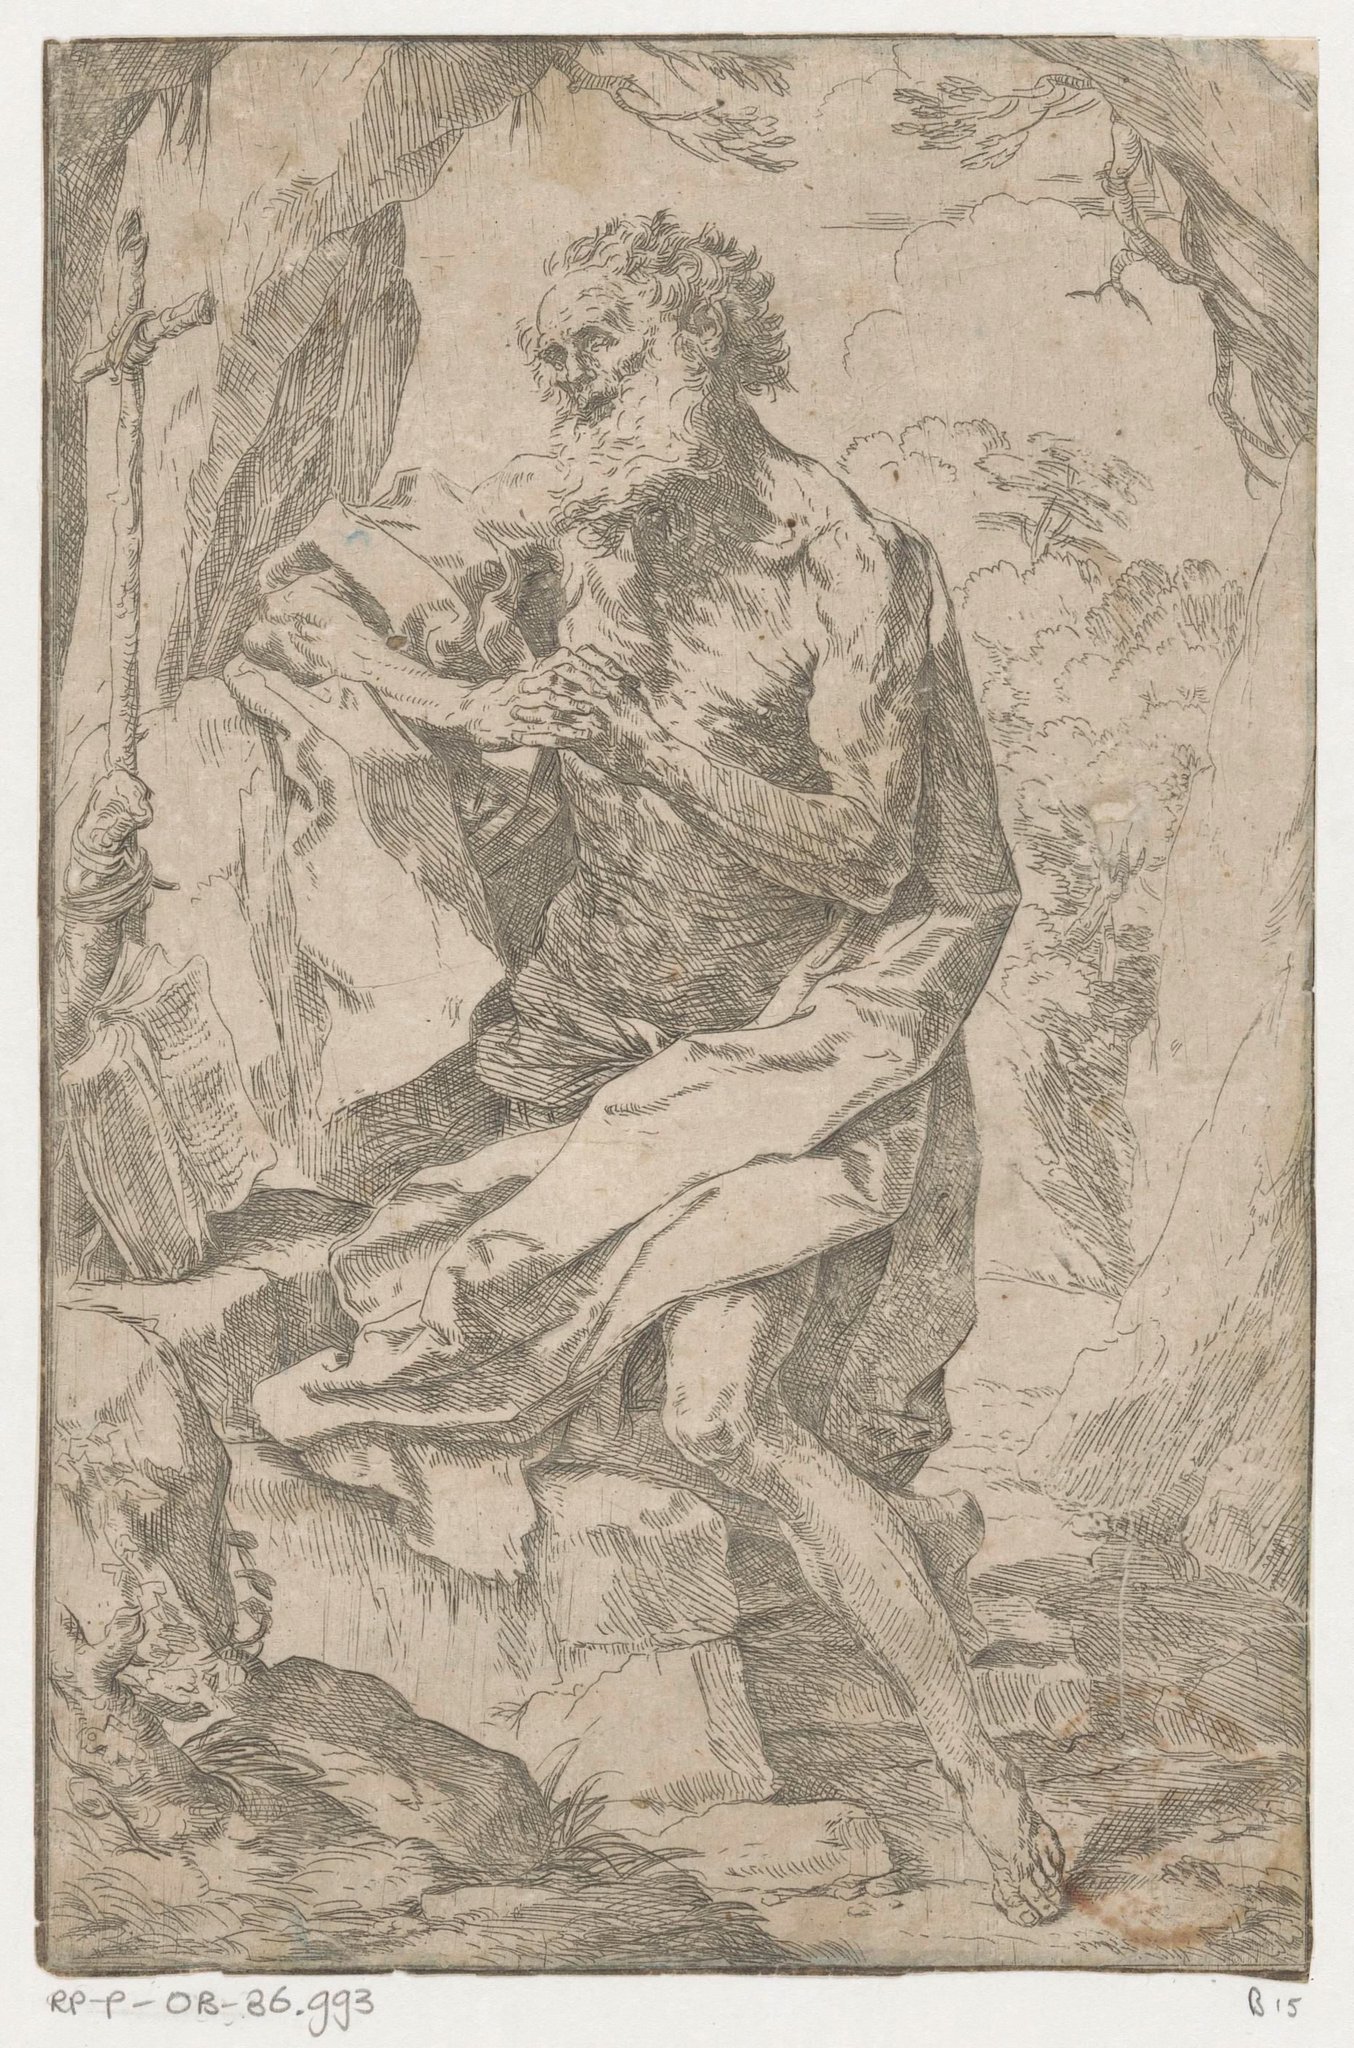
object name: print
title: De heilige Hieronymus in de wildernis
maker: guido reni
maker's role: draughtsman, painter, print maker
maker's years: 1575-1642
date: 1585-1642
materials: paper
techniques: etching, pen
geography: italy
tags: the monk and hermit jerome (hieronymus); possible attributes: book, cardinal's hat, crucifix, hour-glass, lion, skull, stone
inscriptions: collector's mark: Lugt 240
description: De heilige Hieronymus in aanbidding voor een crucifix in een grot in de wildernis.